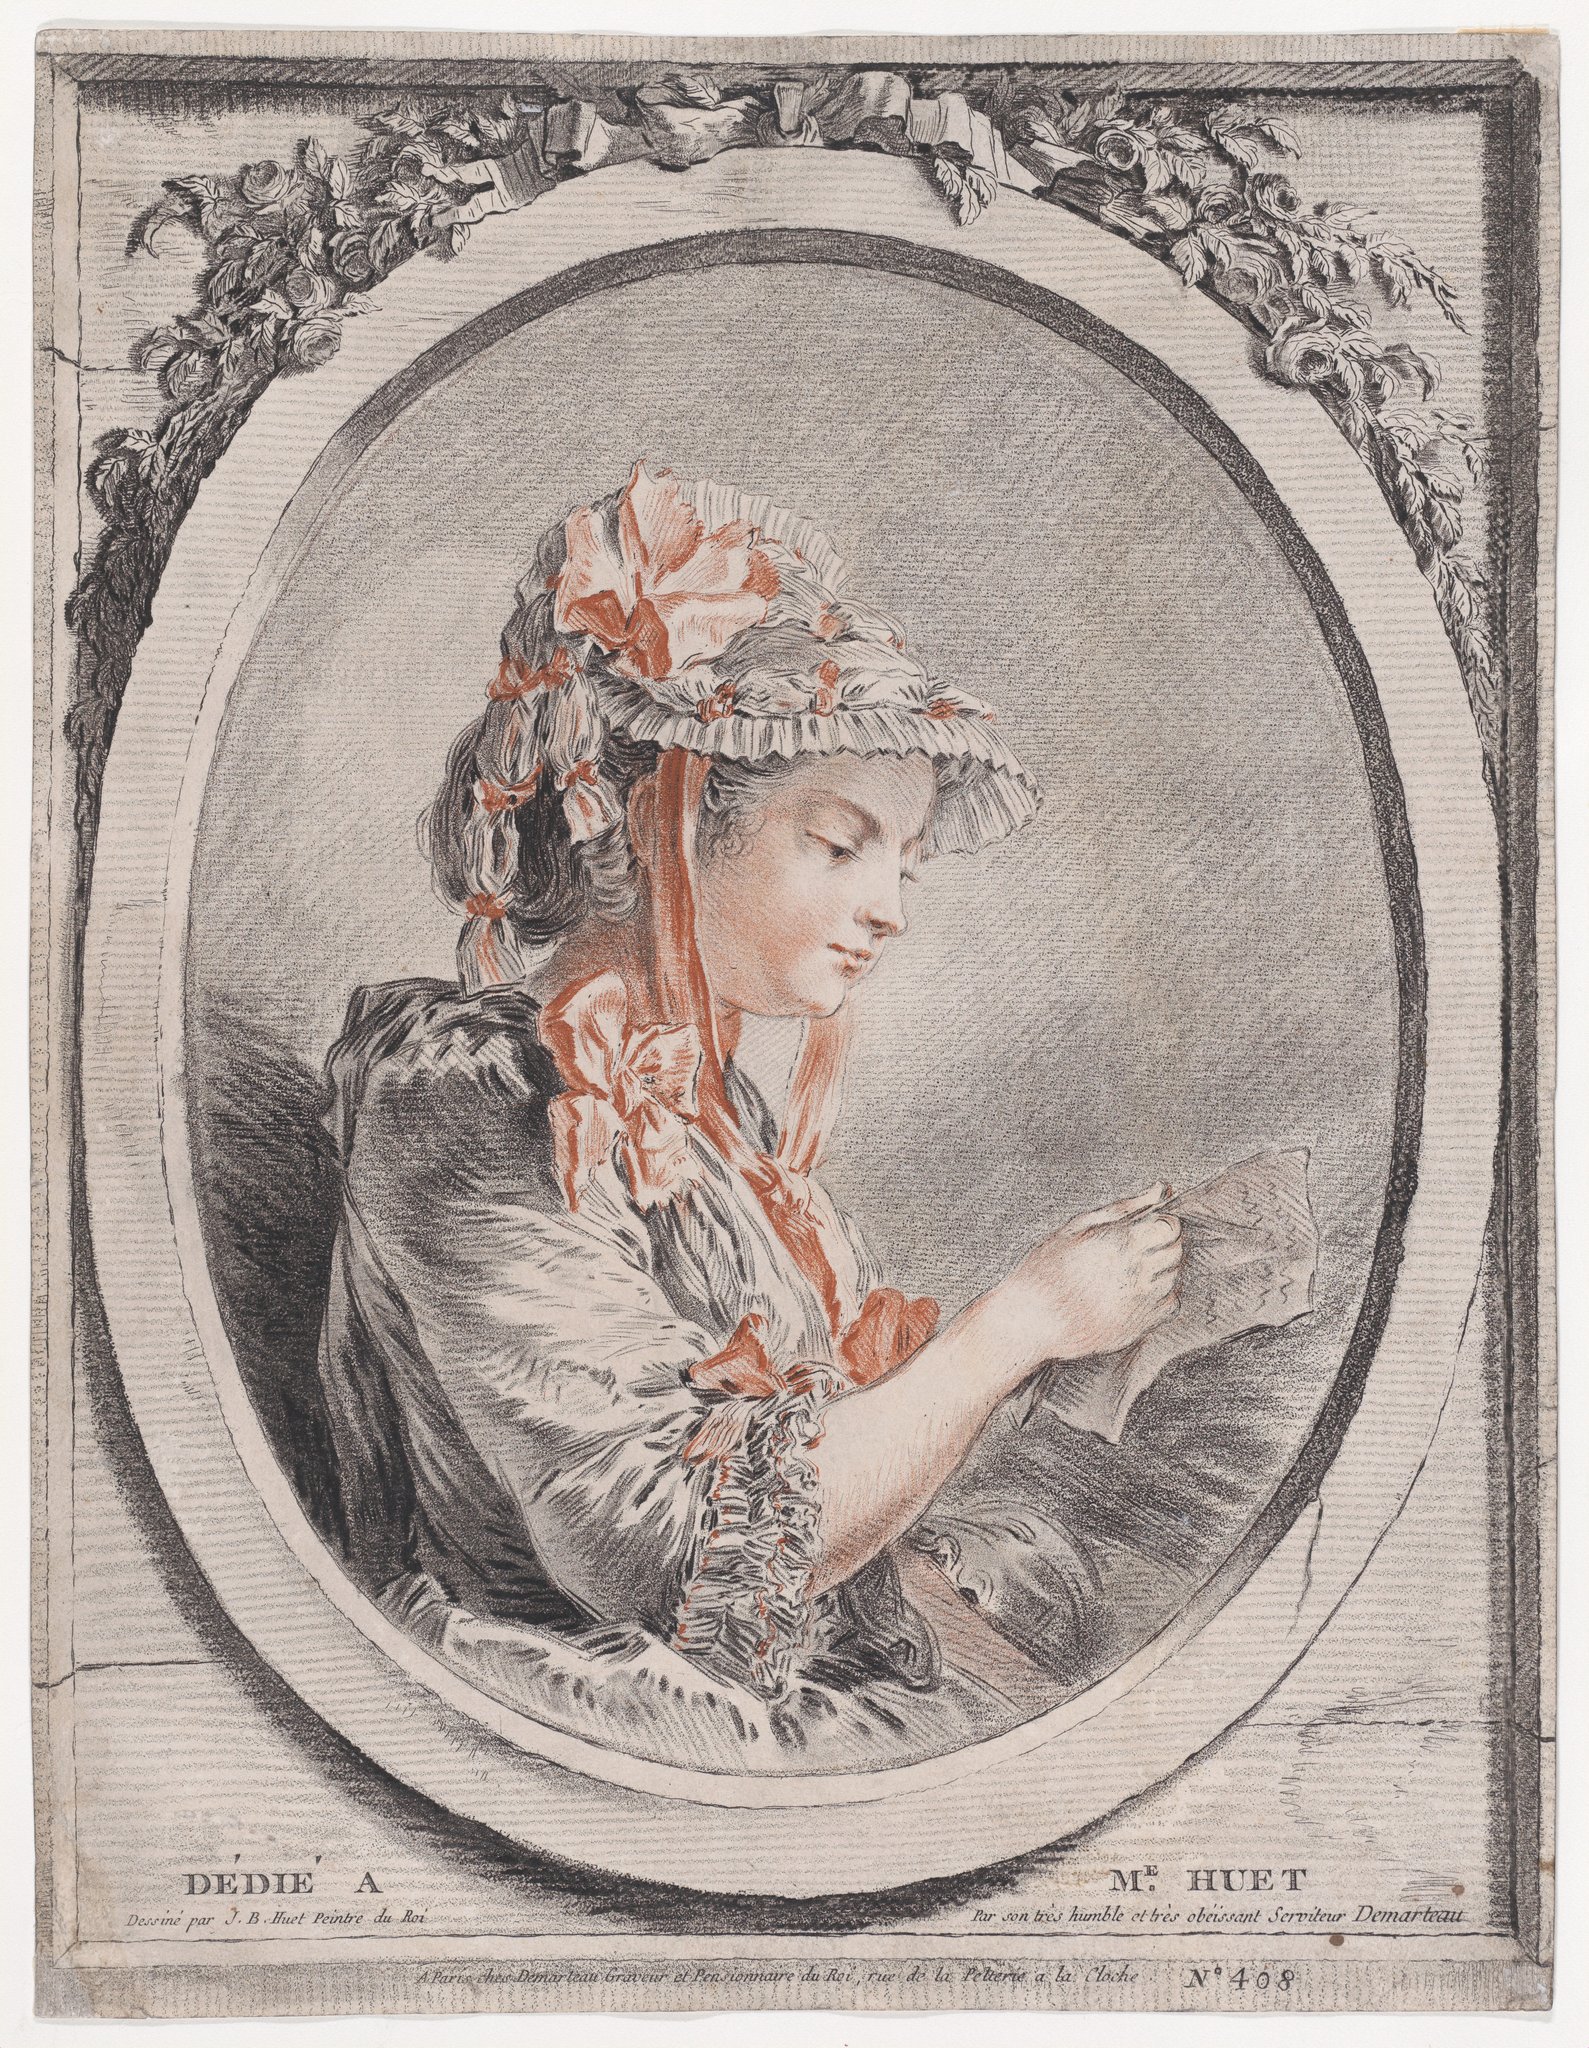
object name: print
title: Une Liseuse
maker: gilles demarteau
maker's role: artist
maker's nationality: french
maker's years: 1722-1776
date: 1742-1776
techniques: printmaking, etching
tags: women,reading